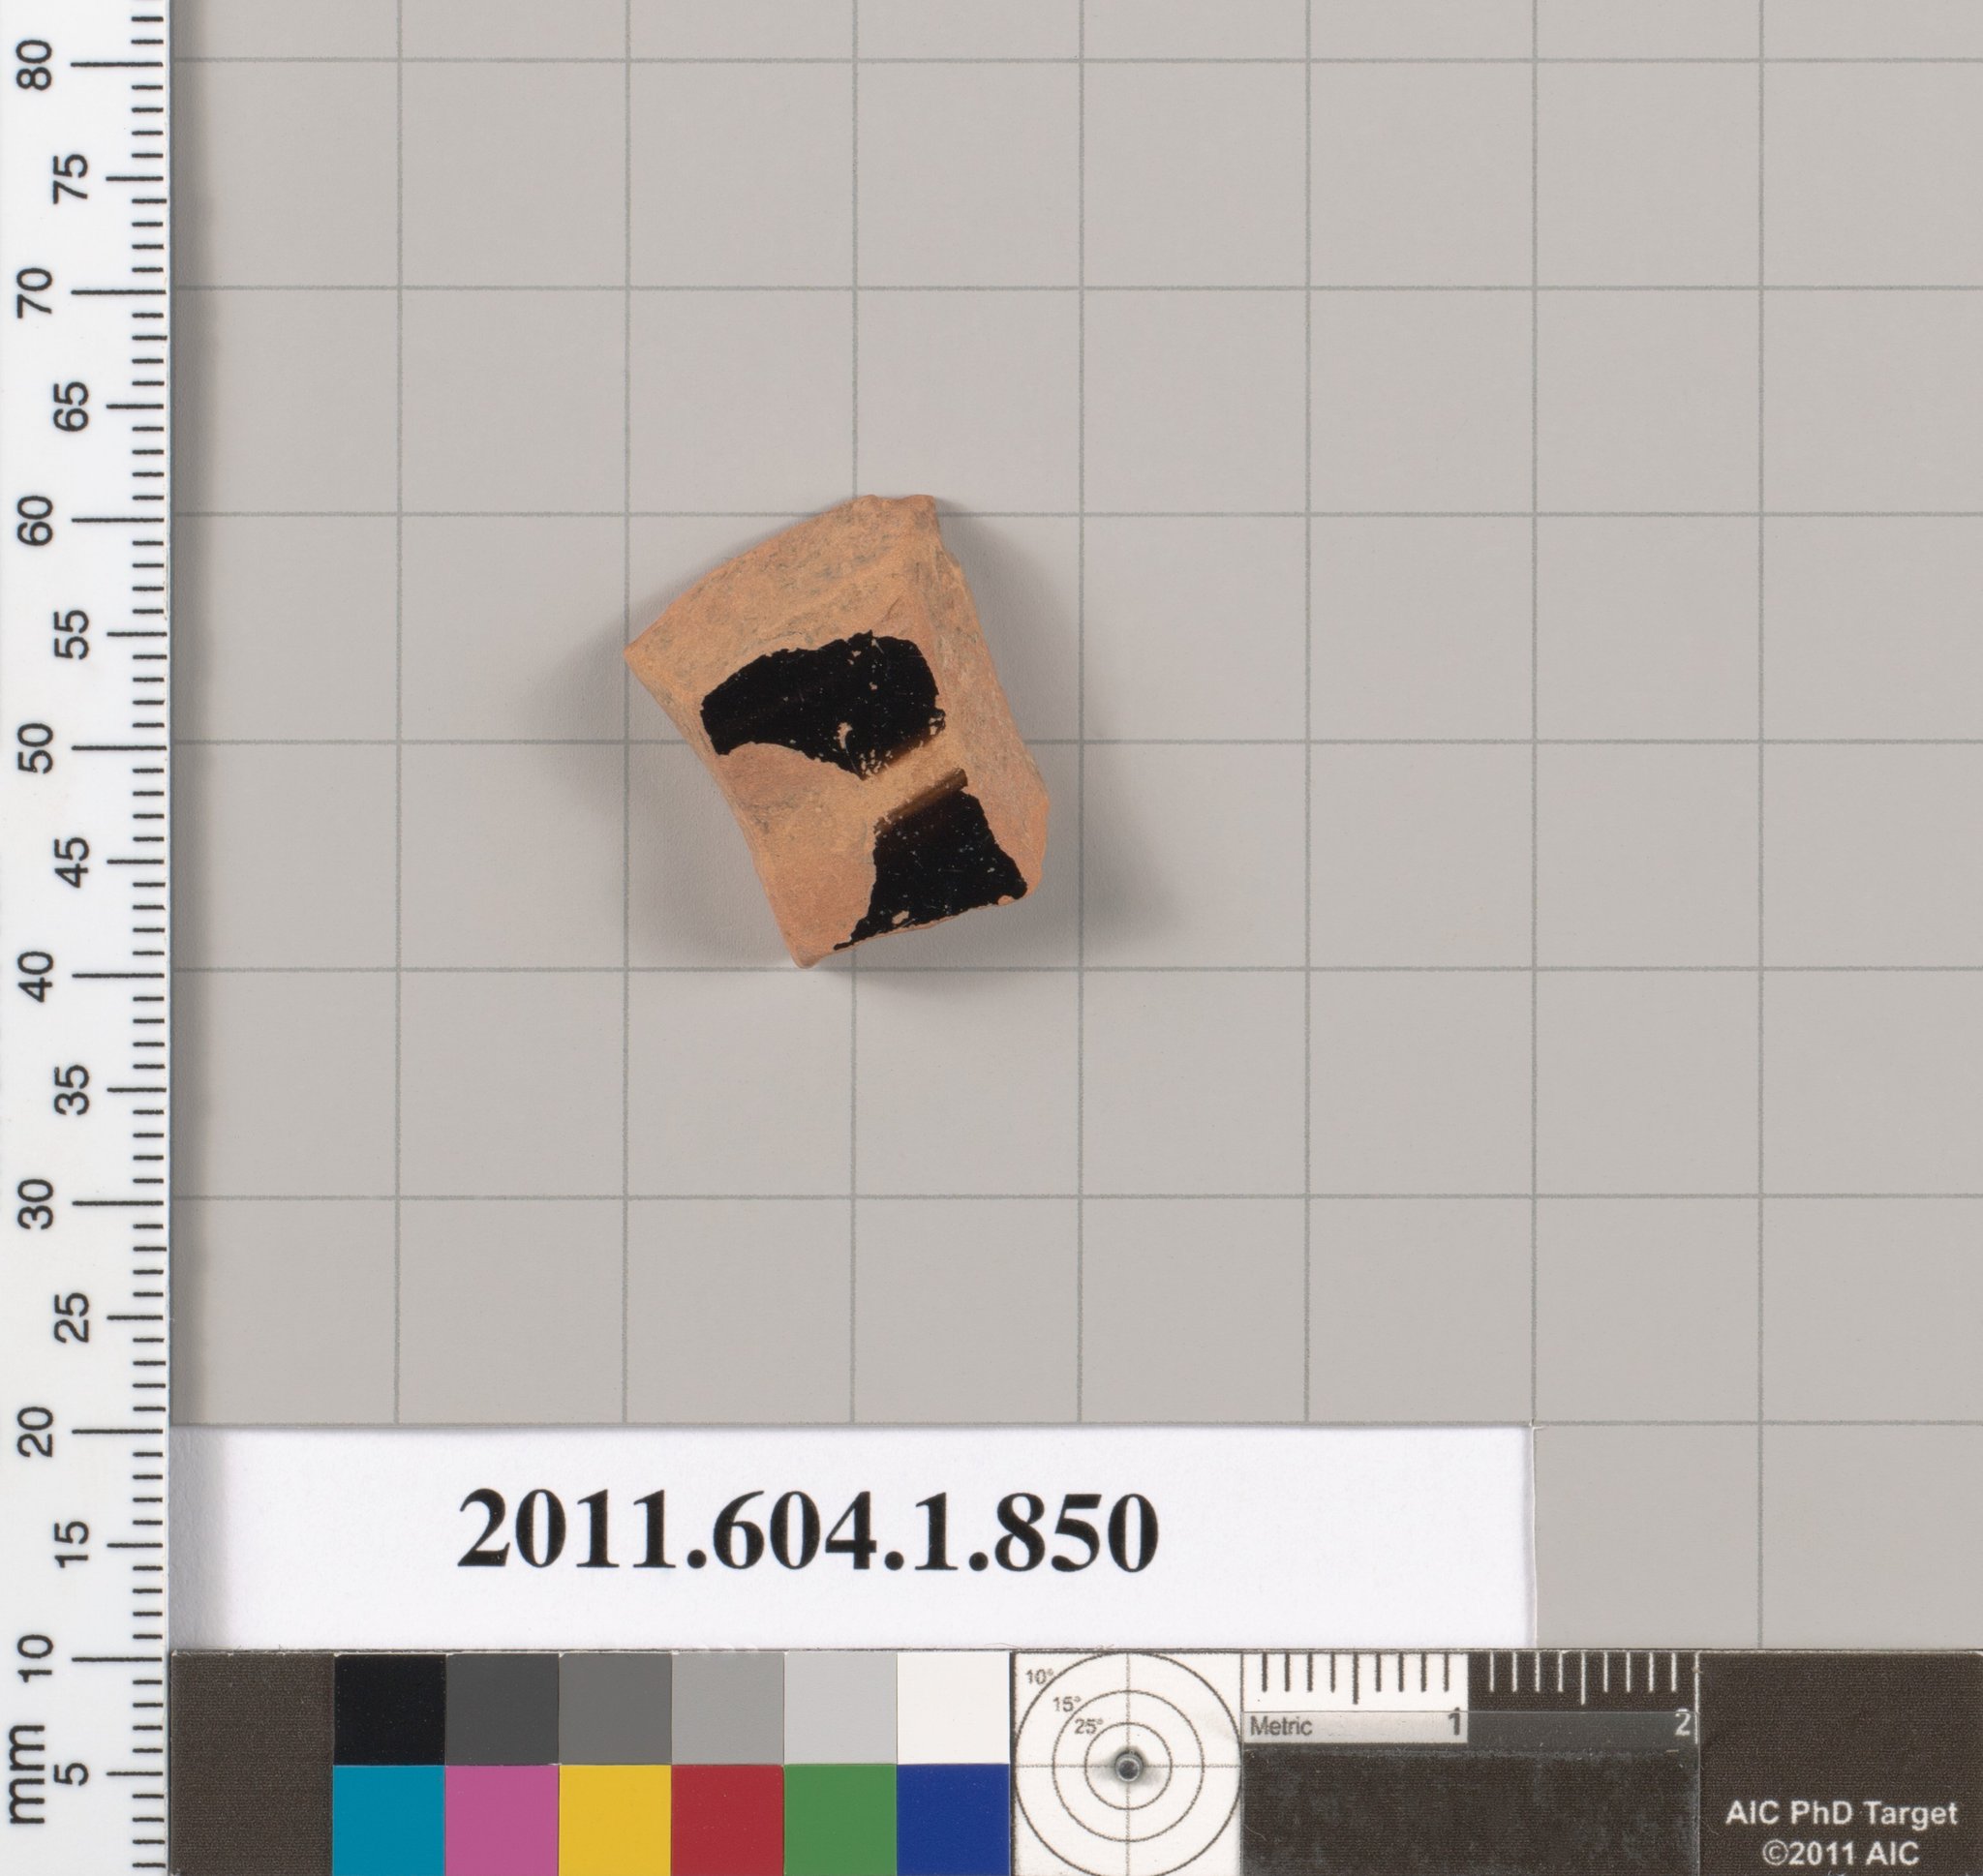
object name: kylix fragment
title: Terracotta fragment of a kylix (drinking cup)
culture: greek, attic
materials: terracotta